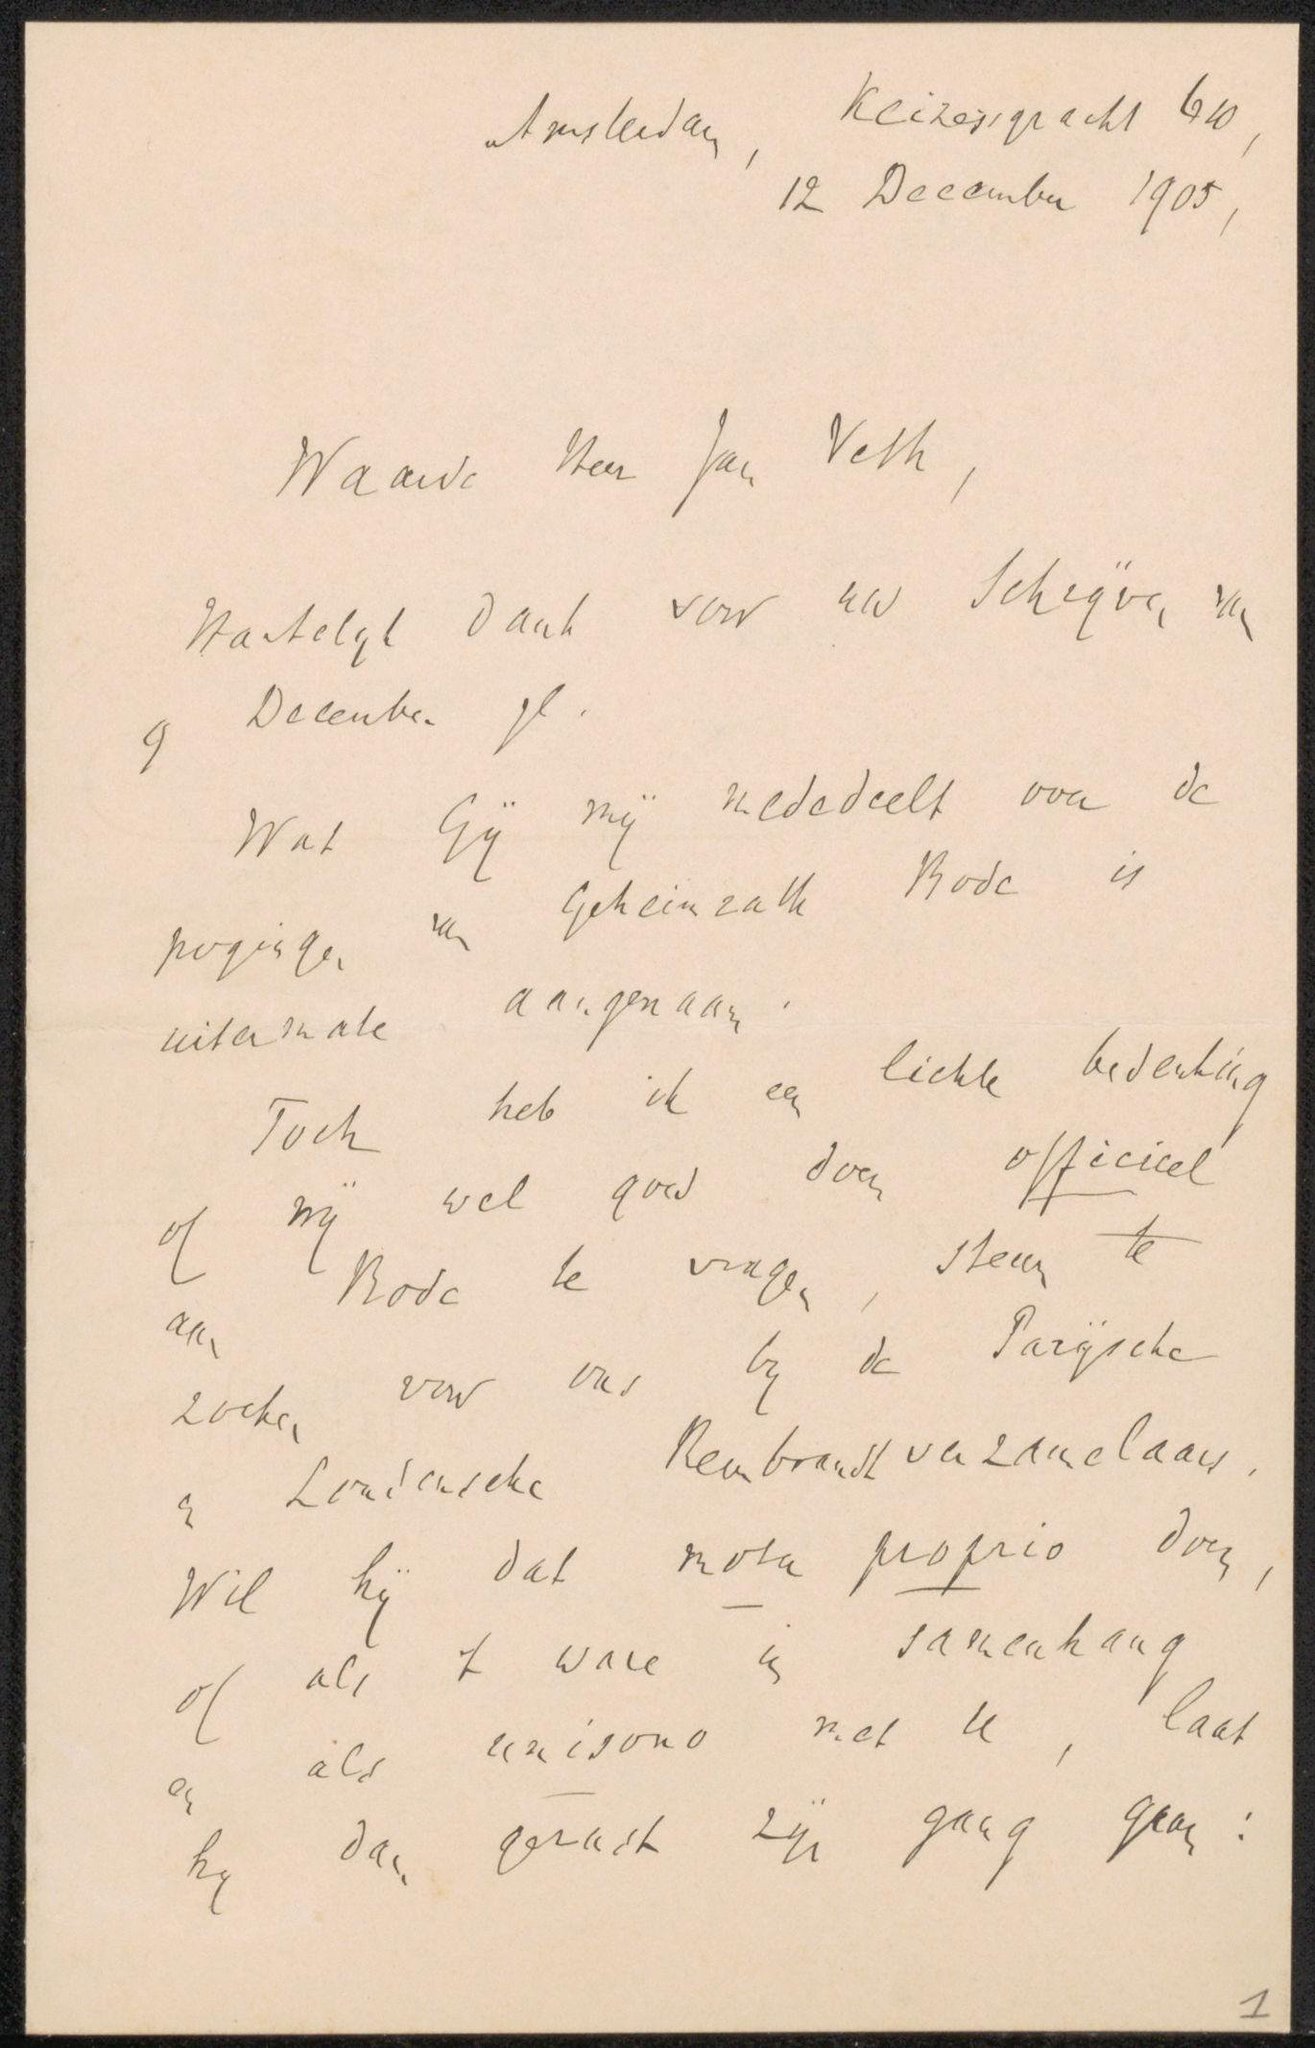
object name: letter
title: Brief aan Jan Veth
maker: hendrick peter godfried quack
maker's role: econoom, geschiedschrijver, hoogleraar, jurist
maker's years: 1834-1917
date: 1905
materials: ink, paper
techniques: pen, writing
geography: amsterdam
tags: dordrecht, amsterdam, painter, draughtsman, jan veth, rembrandt van rijn, berlin, wilhelm von bode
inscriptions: collector's mark: ‘RPK’